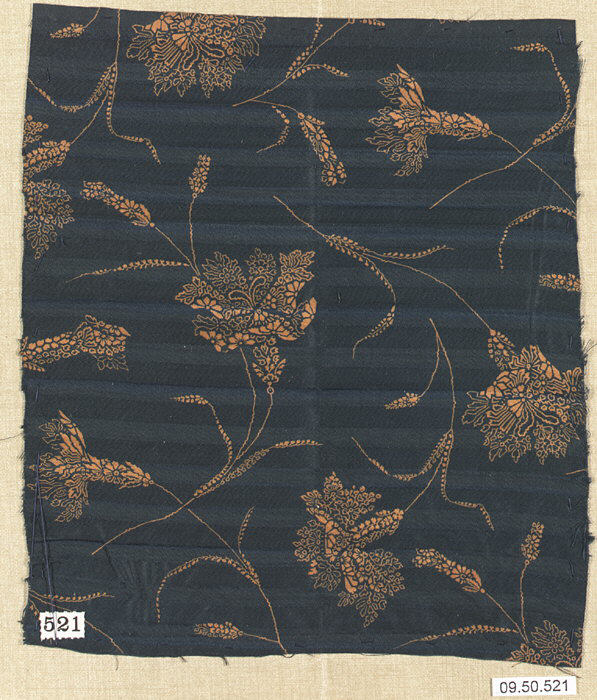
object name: piece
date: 1801-1900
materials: cotton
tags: leaves